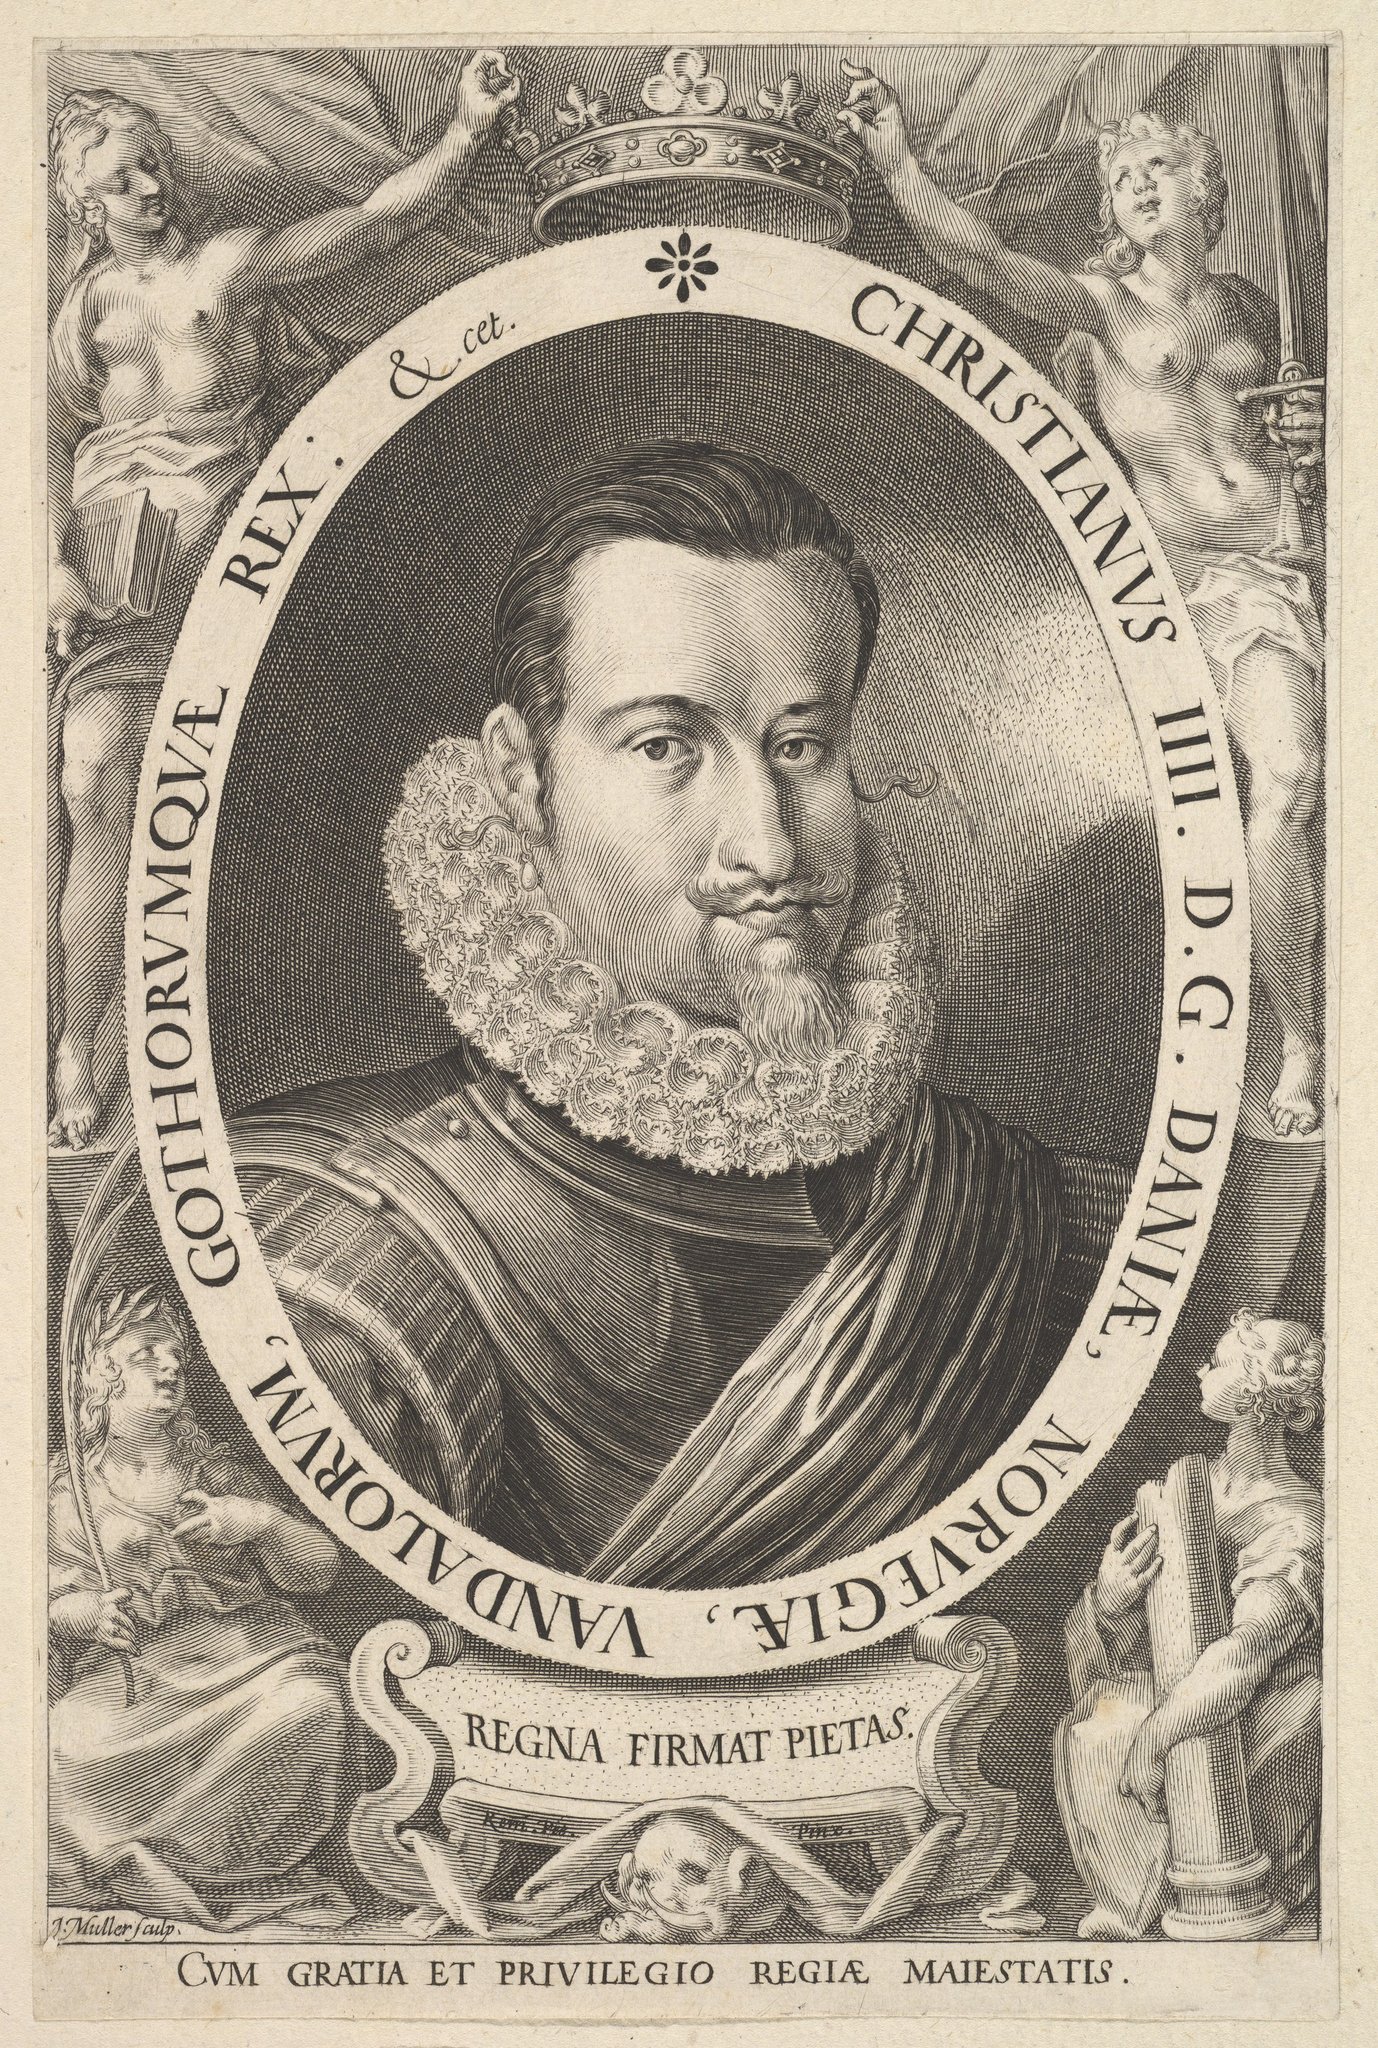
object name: print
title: Portrait of Christian IV, King of Denmark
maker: jan muller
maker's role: artist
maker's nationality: netherlandish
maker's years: 1571-1628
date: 1606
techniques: engraving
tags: kings,men,portraits